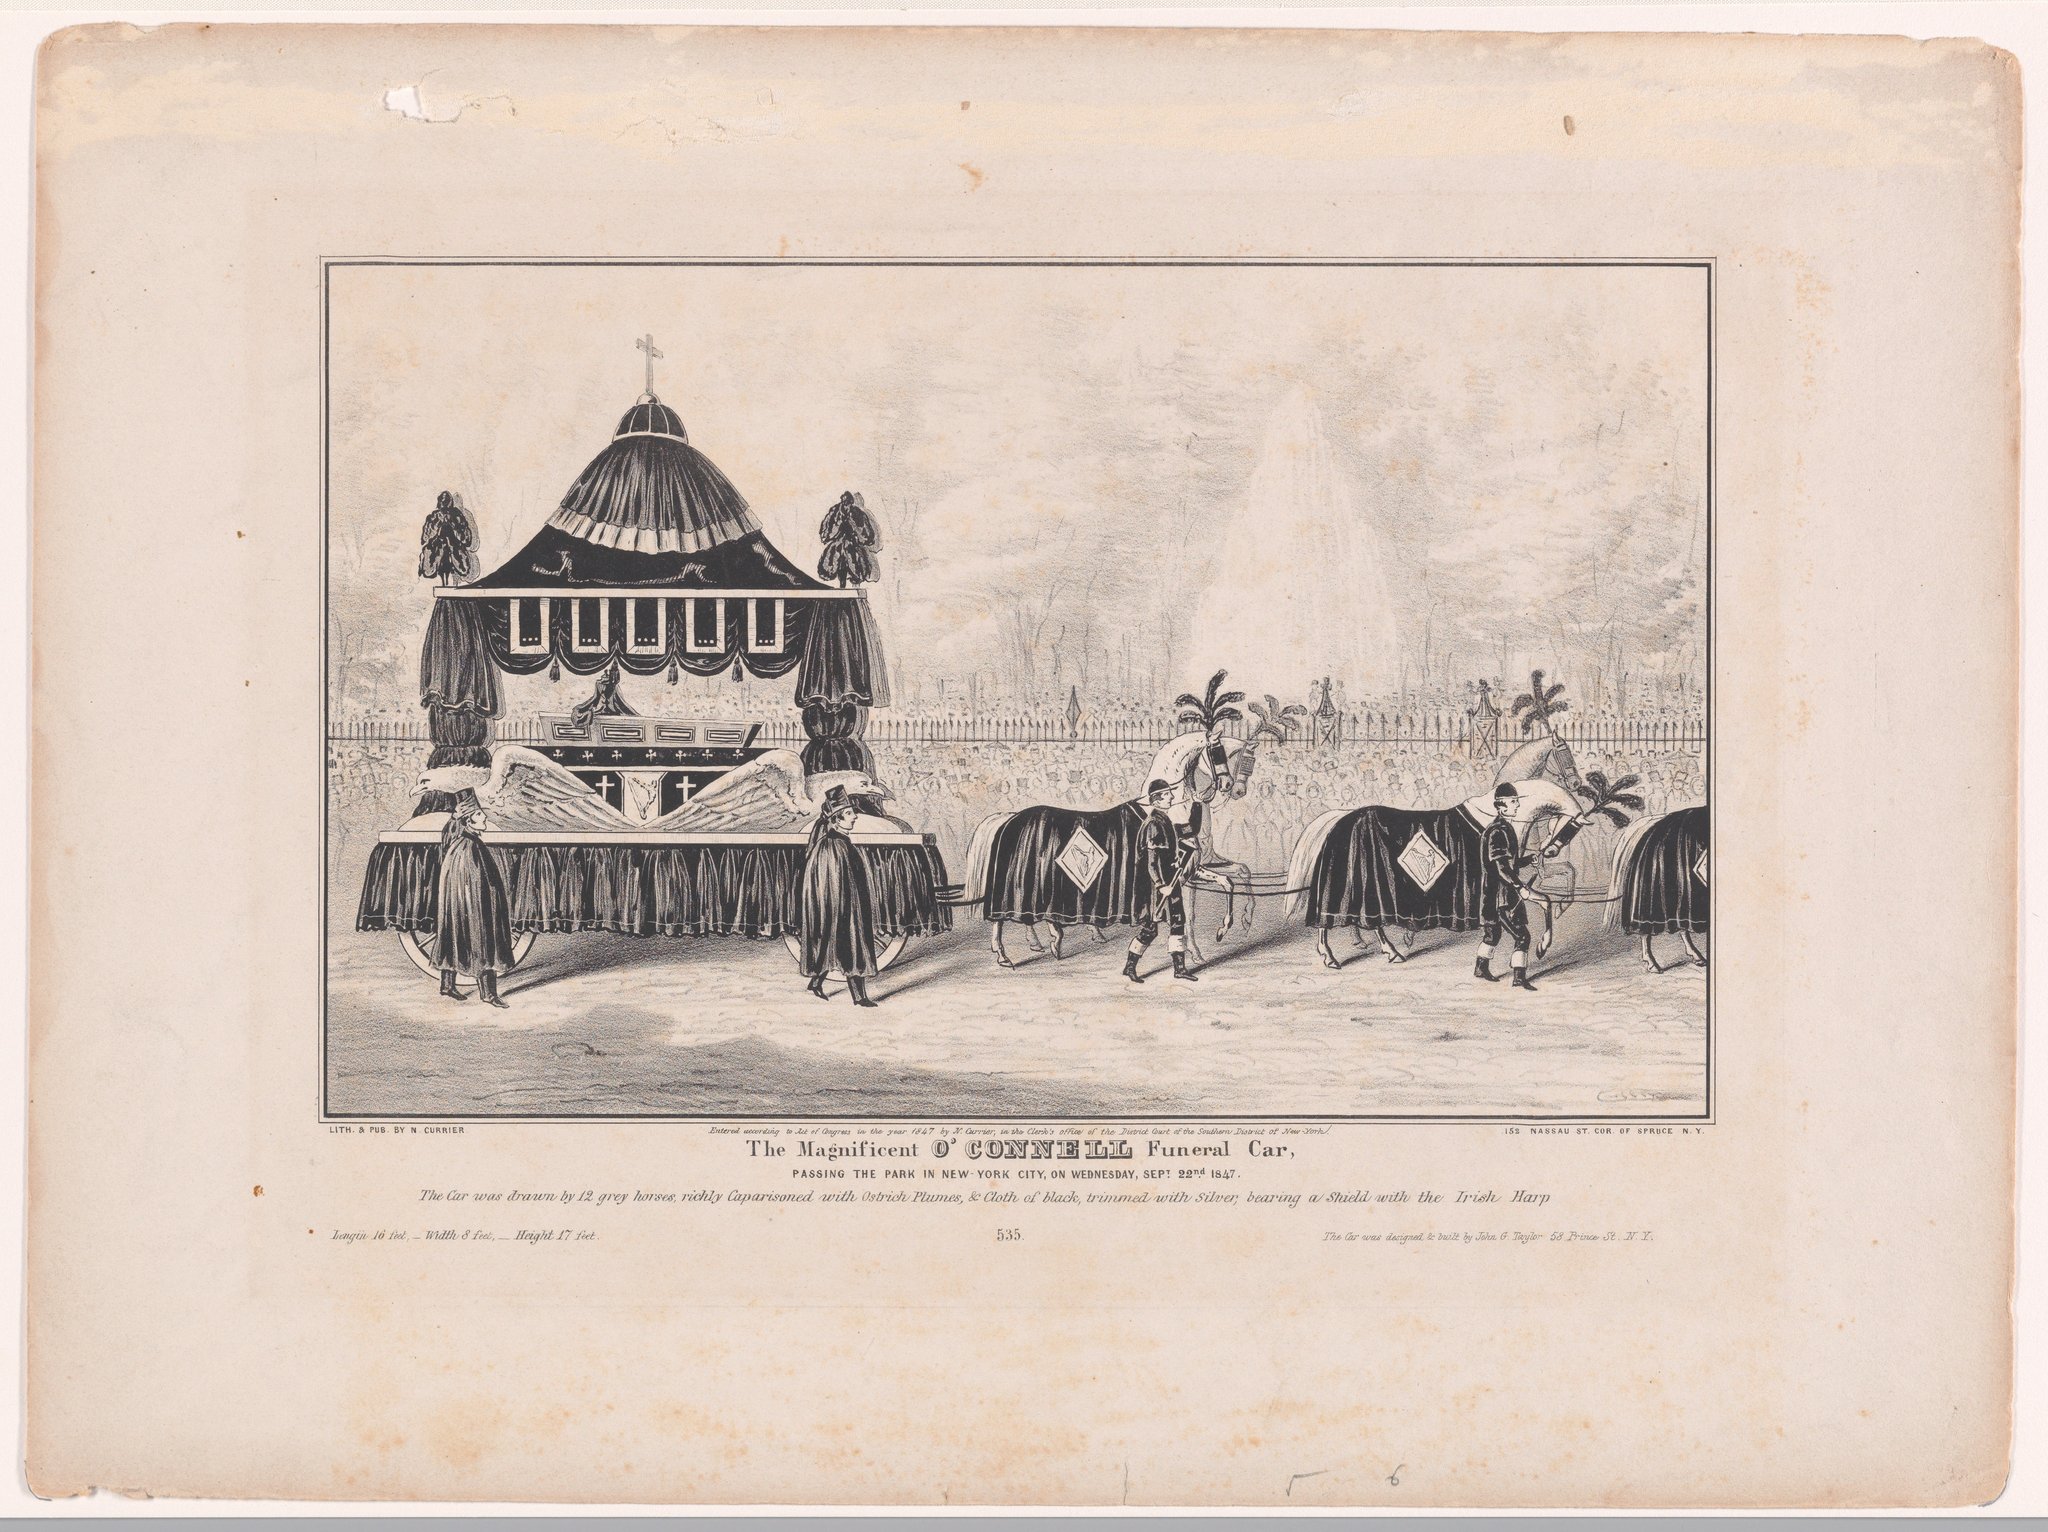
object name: print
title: The Magnificent O'Connell Funeral Car, Passing the Park in New York City, on Wednesday, Sept. 22nd, 1847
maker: nathaniel currier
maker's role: lithographer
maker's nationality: american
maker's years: 1813-1888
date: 1847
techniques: lithograph